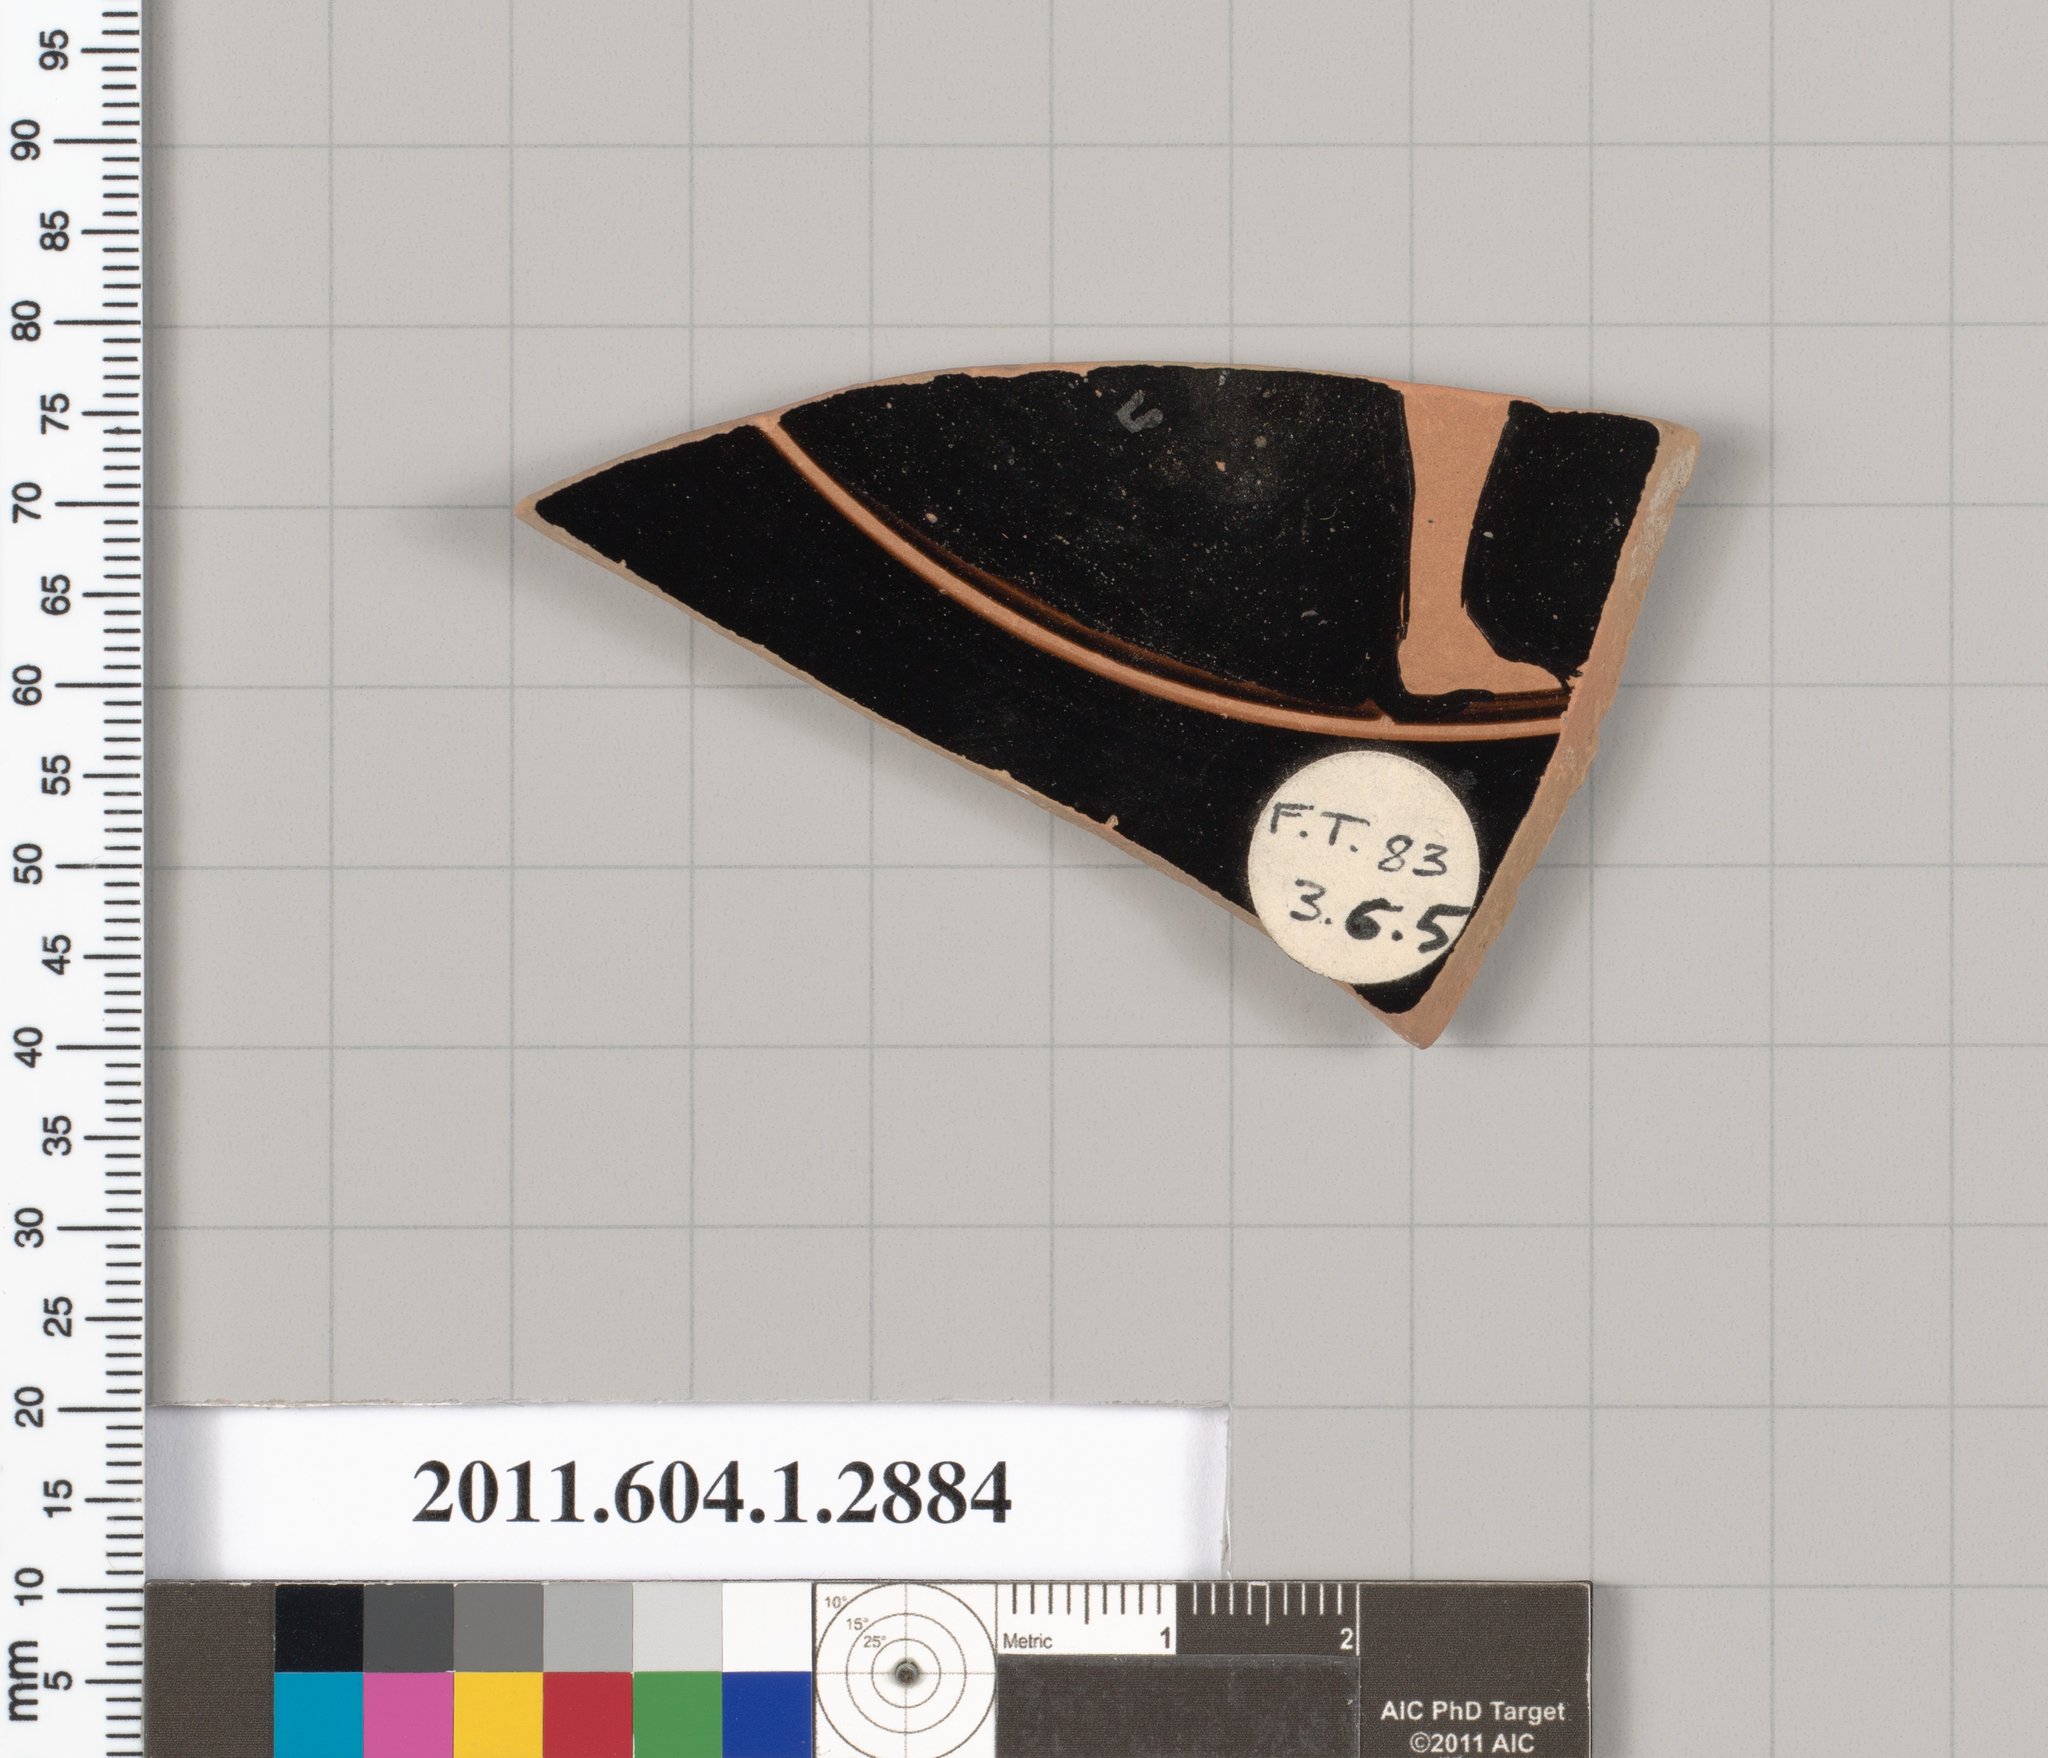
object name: kylix fragment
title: Terracotta fragment of a kylix (drinking cup)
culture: greek, attic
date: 520-500 BCE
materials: terracotta